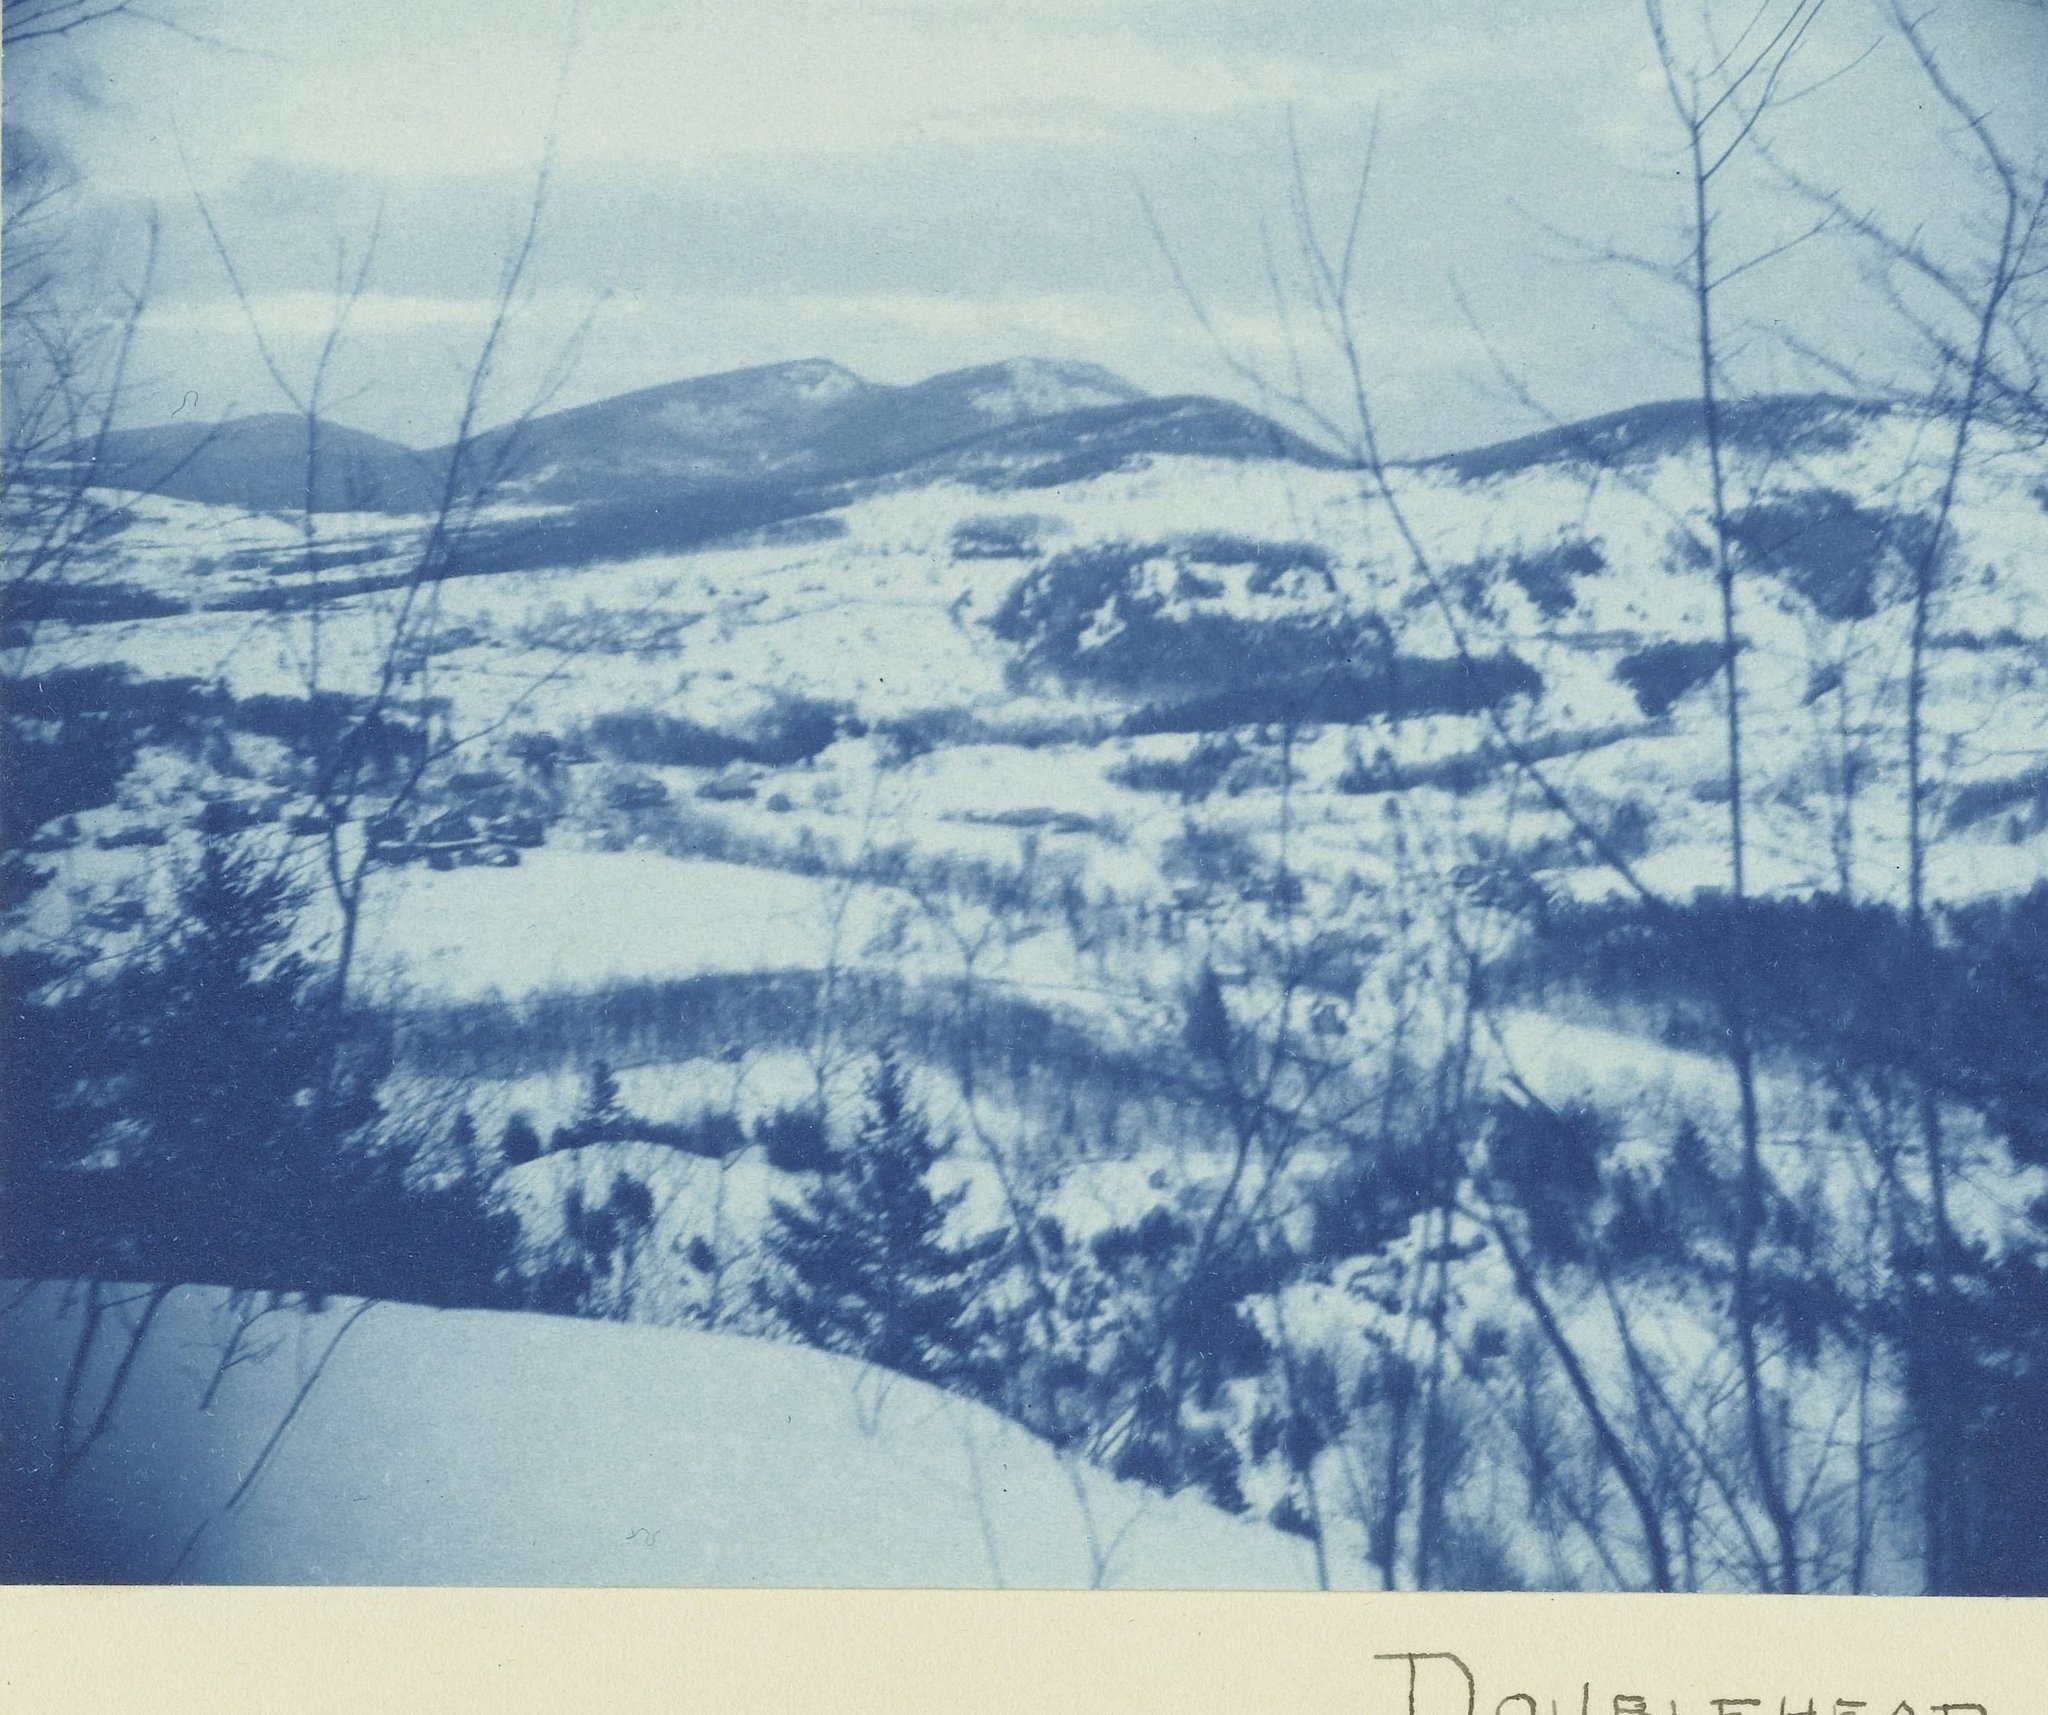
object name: photograph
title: Landschap in de sneeuw: Doublehead, gezien vanaf the Duck's Head, NH, Verenigde Staten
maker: charlotte m. endicott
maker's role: fotograaf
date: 1899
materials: photographic support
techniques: cyanotype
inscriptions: title: ‘DOUBLEHEAD, / FROM THE DUCK'S HEAD. / FEB. 19. 1899’